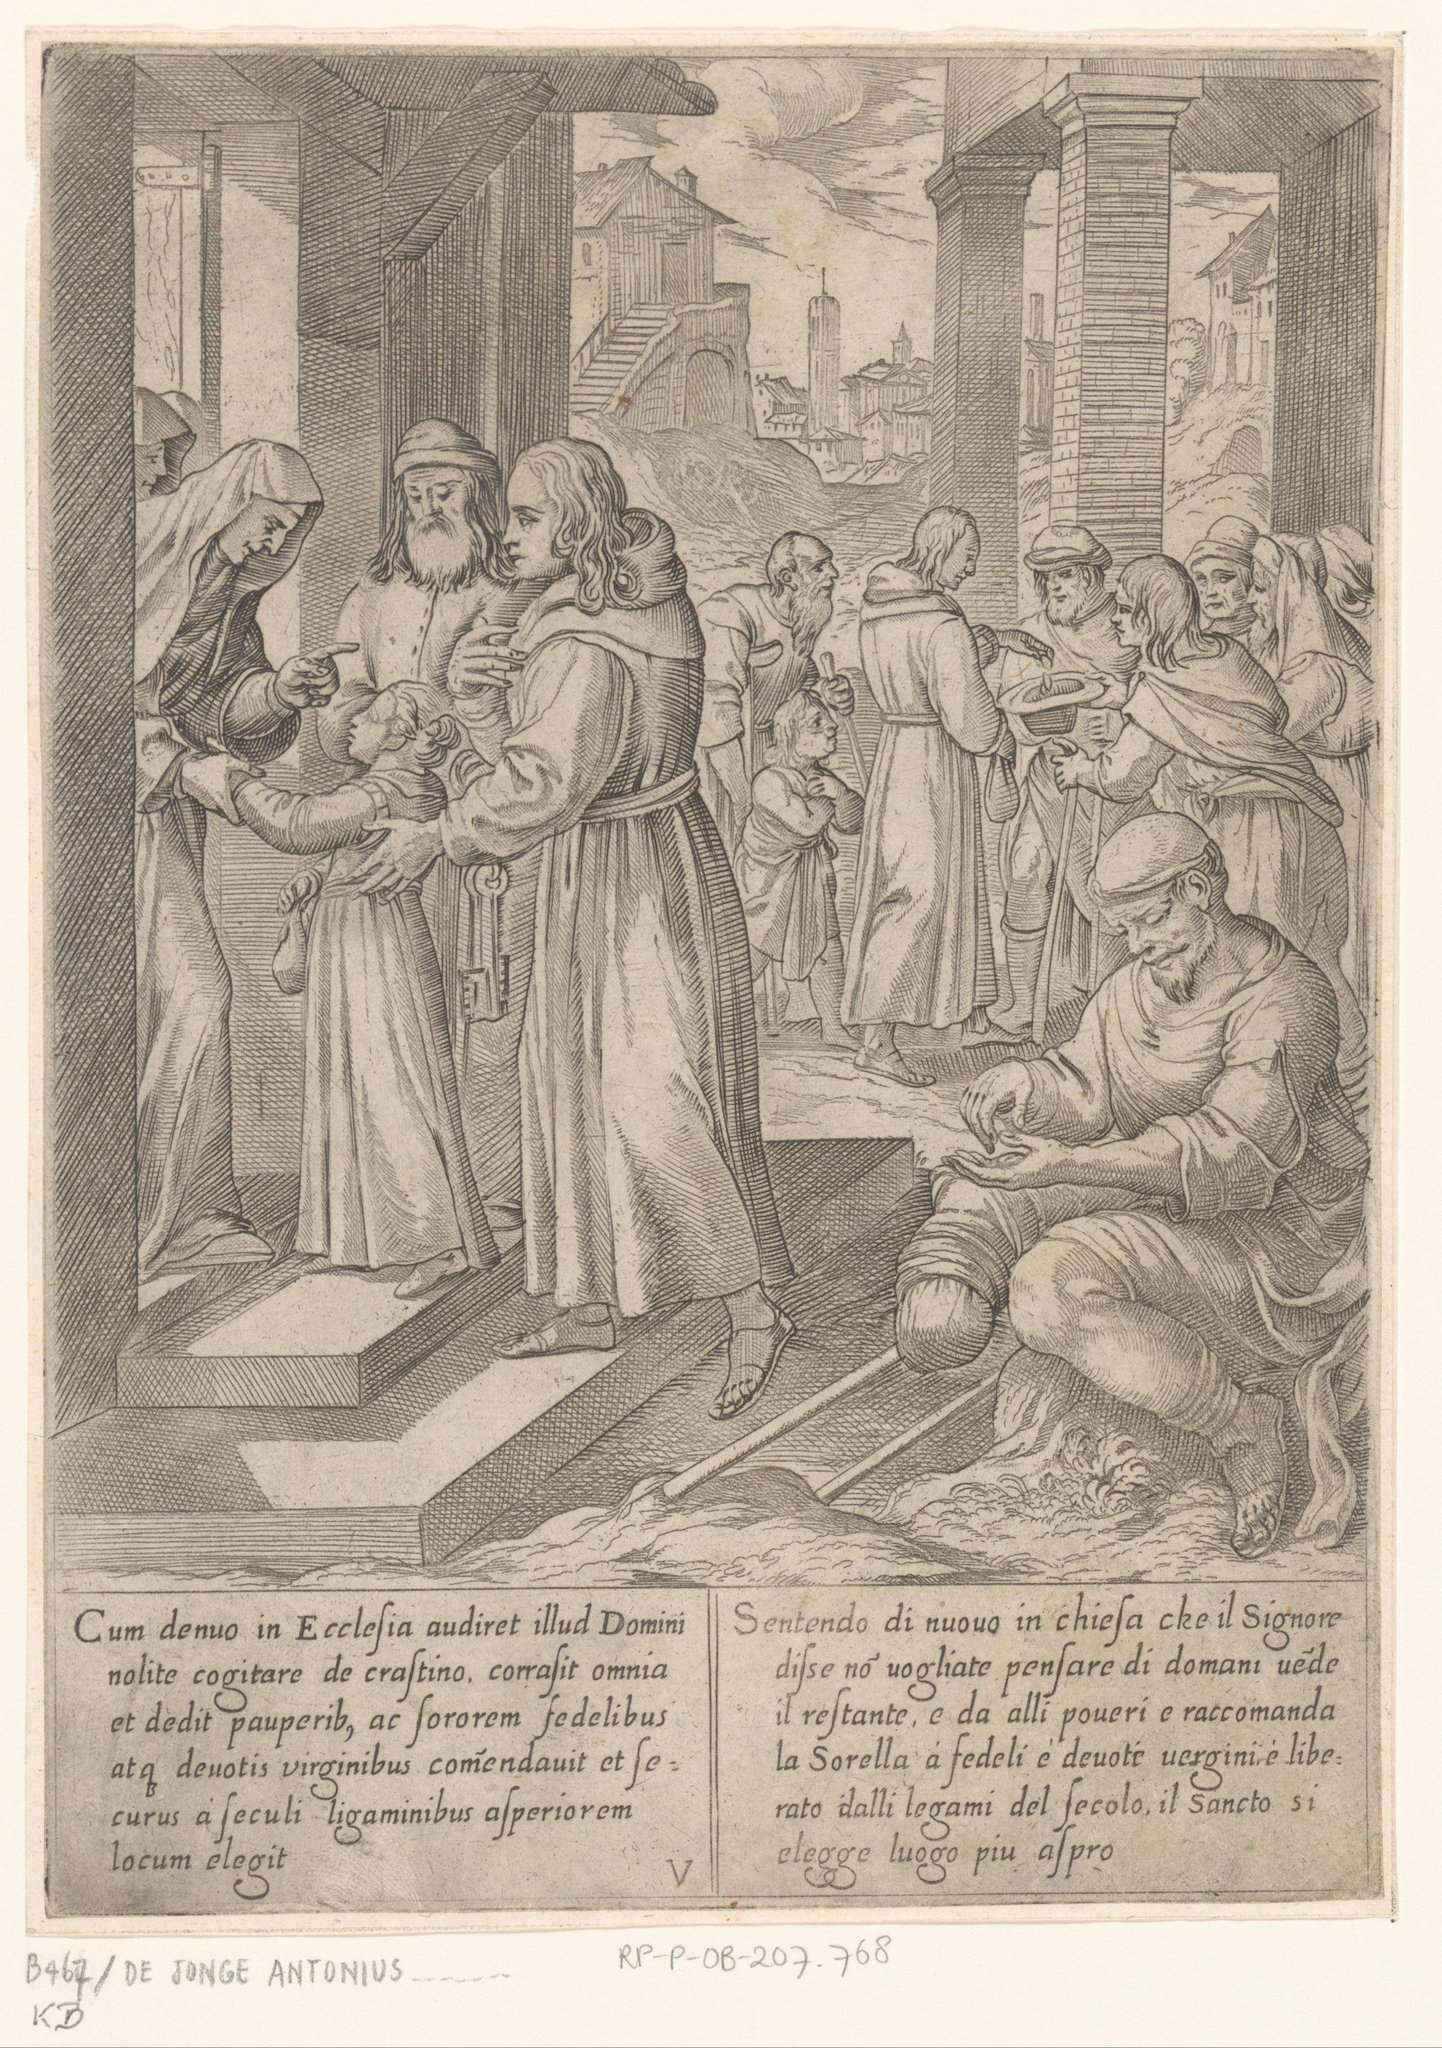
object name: print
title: Het leven van de heilige Antonius de Grote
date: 1598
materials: paper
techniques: etching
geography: rome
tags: disabilities, deformations, beggar, the hermit antony abbot (antonius abbas) of egypt, also called the great; possible attributes: bell, book, t-shaped staff, flames, pig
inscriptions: collector's mark: Lugt 240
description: Deze prent maakt deel uit van een reeks van 27 prenten (+ titelprent) over het leven van de heilige Antonius, naar een frescocyclus in de S. Antonio Abbate in Rome door Giovanni Battista Lombardelli en Niccolò Circignani.